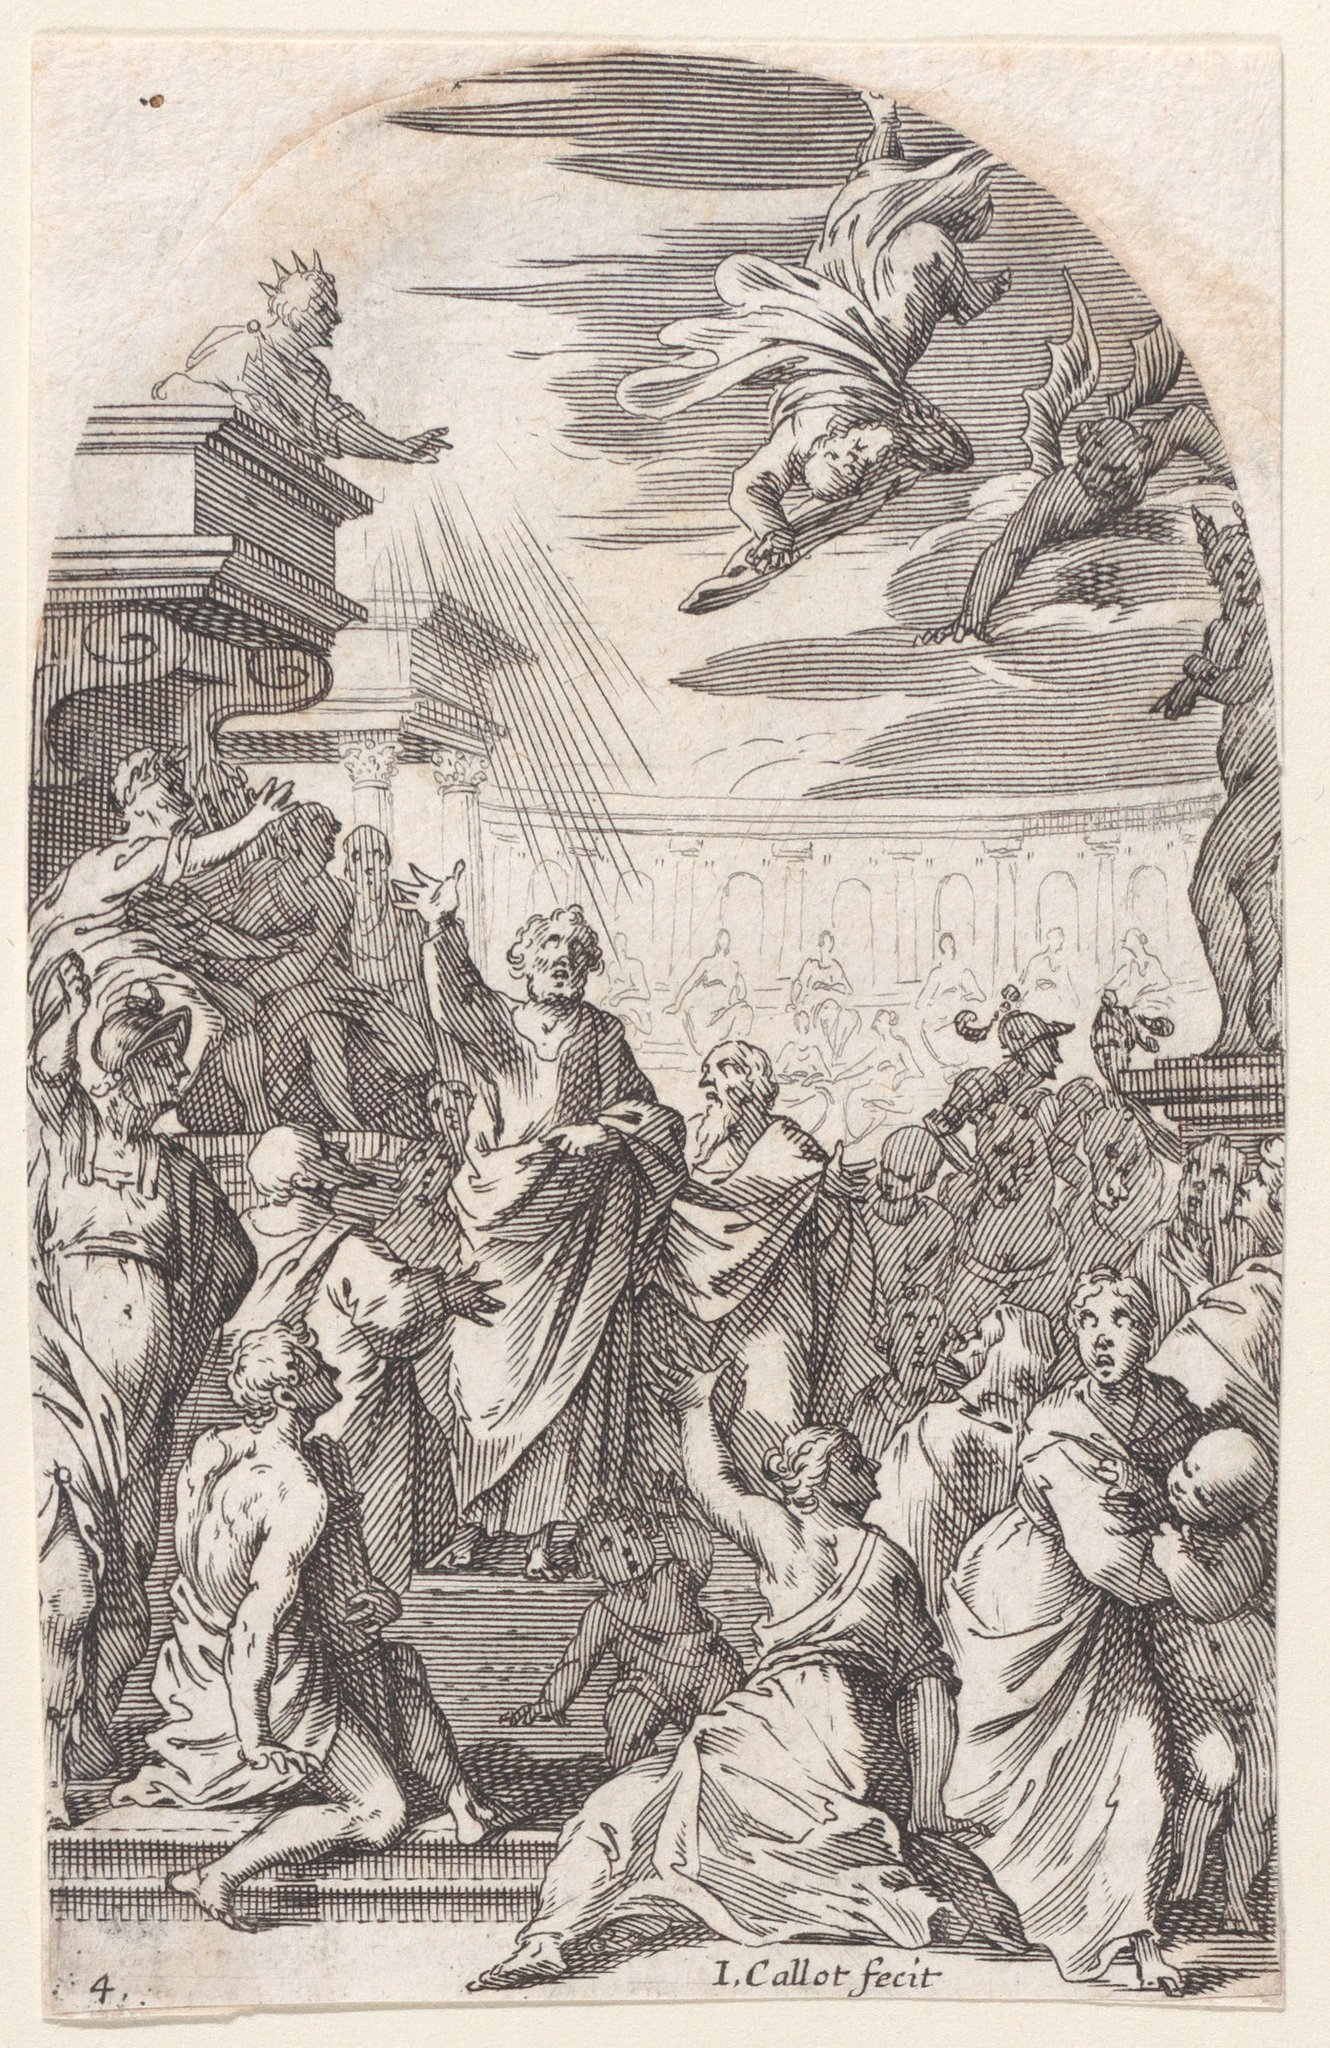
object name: print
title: The Fall of Simon the Magician, plate 4 from "Les Tableaux de Rome, Les Eglises Jubilaires" (The Paintings of Rome, The Churches Jubilee)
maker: jacques callot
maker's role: artist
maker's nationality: french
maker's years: 1592-1635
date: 1607-1611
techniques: engraving